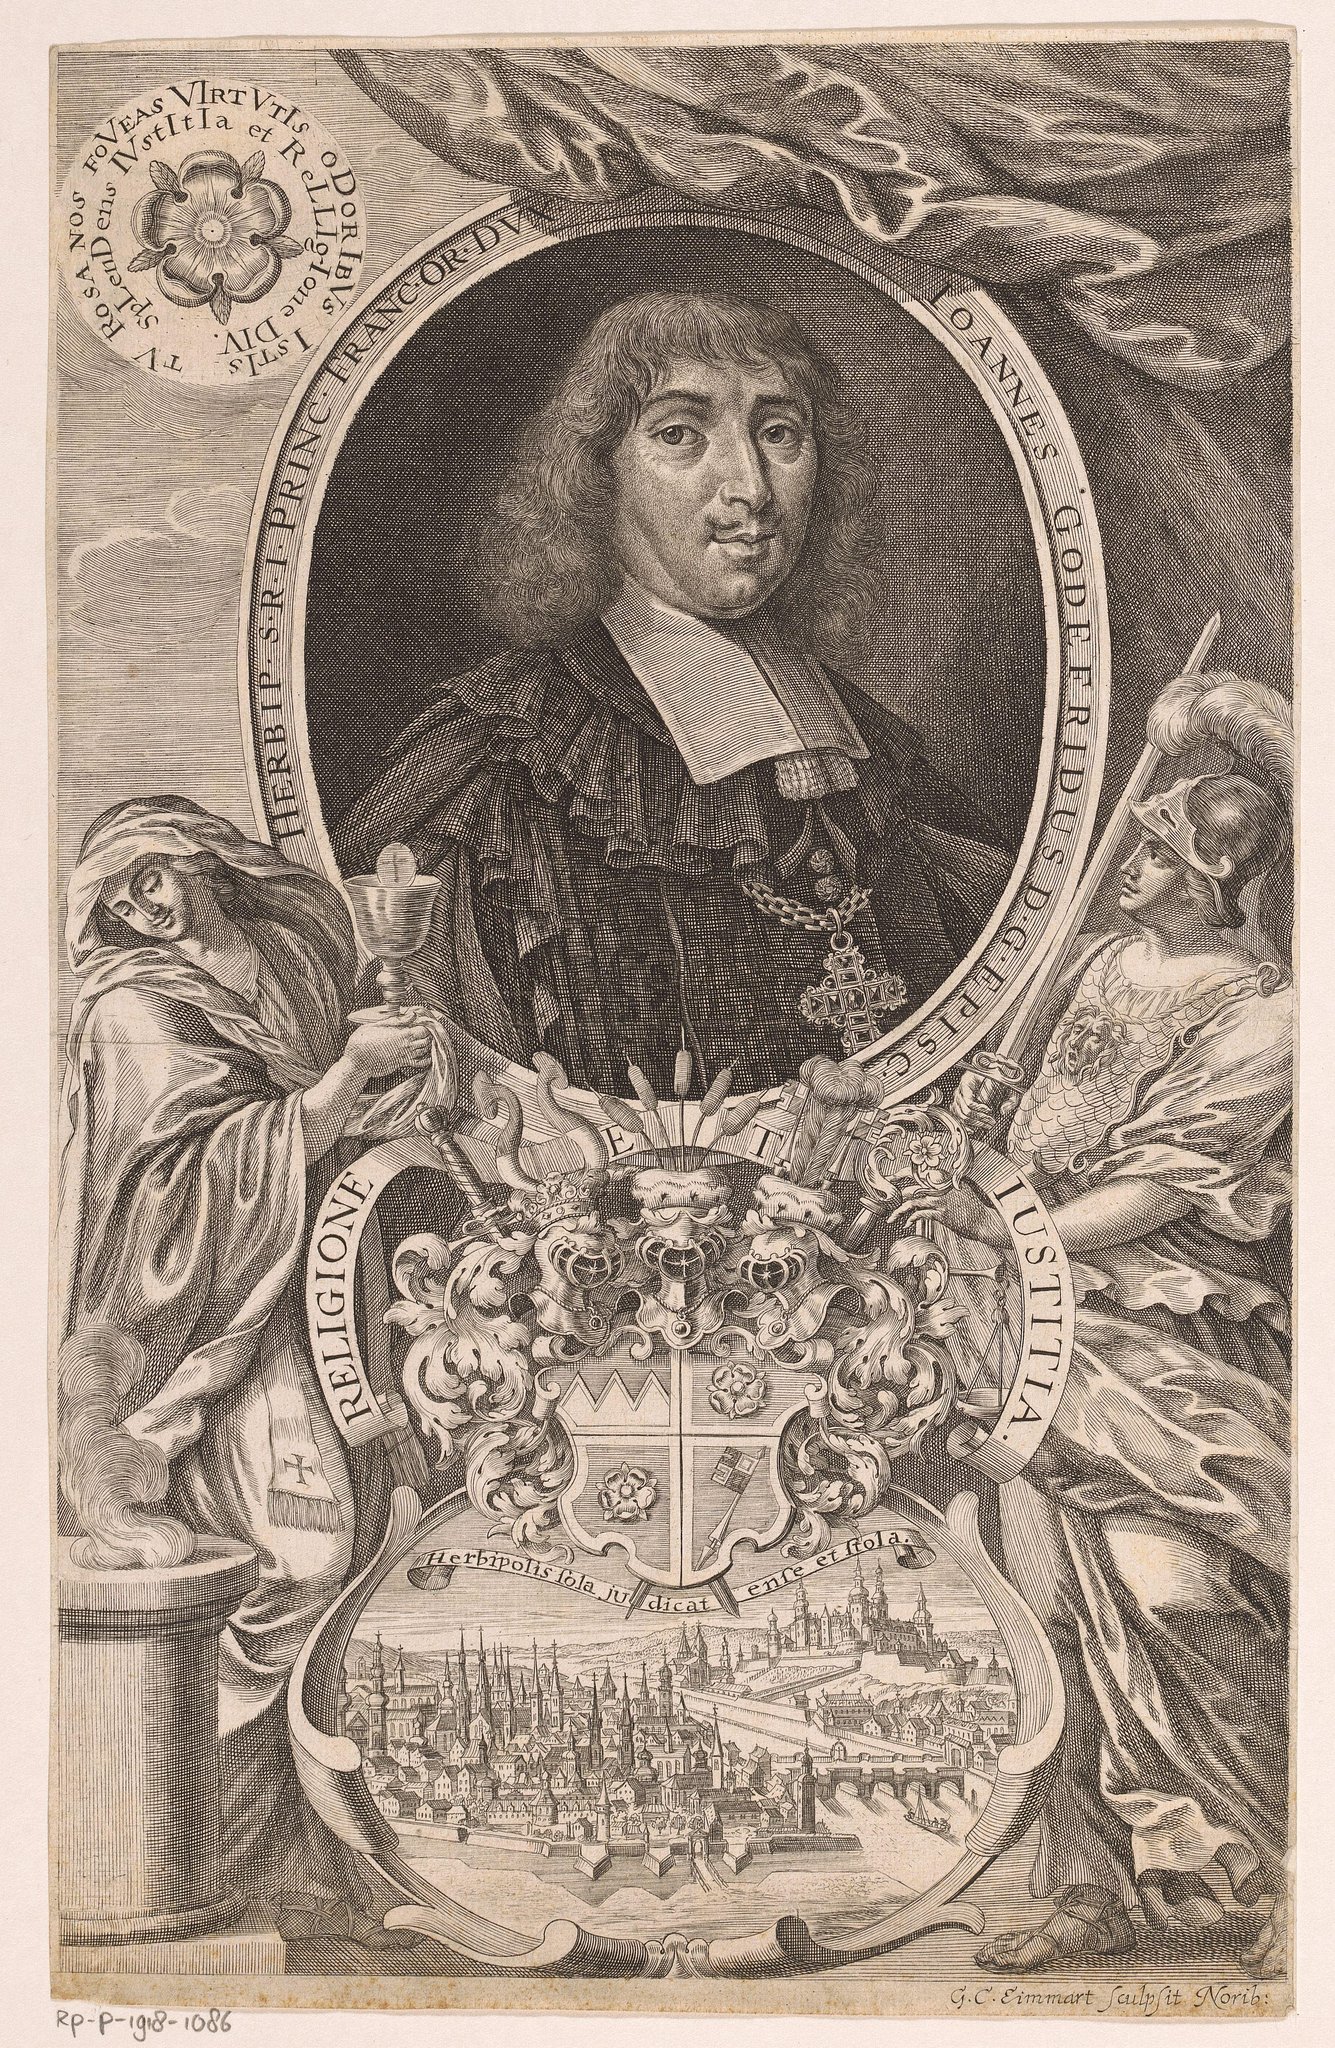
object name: print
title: Portret van Johann Gottfried von Guttenberg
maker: georg christoph eimmart (ii)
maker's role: print maker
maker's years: 1638-1705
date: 1655-1705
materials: paper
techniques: engraving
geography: nuremberg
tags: johann gottfried von guttenberg, city-view in general; 'veduta', (feigned) picture curtain, ornament ~ medallion, historical persons, justitia (justice) as roman personification, the church personified, 'ecclesia', usually with chalice and banner, ornament ~ cartouche, flowers: rose, armorial bearing, heraldry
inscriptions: collector's mark: Lugt 2233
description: Portret in medaillon boven een cartouche met wapenschild en stadsgezicht van Würzburg. De cartouche wordt geflankeerd door personificaties van de religie en rechtvaardigheid.